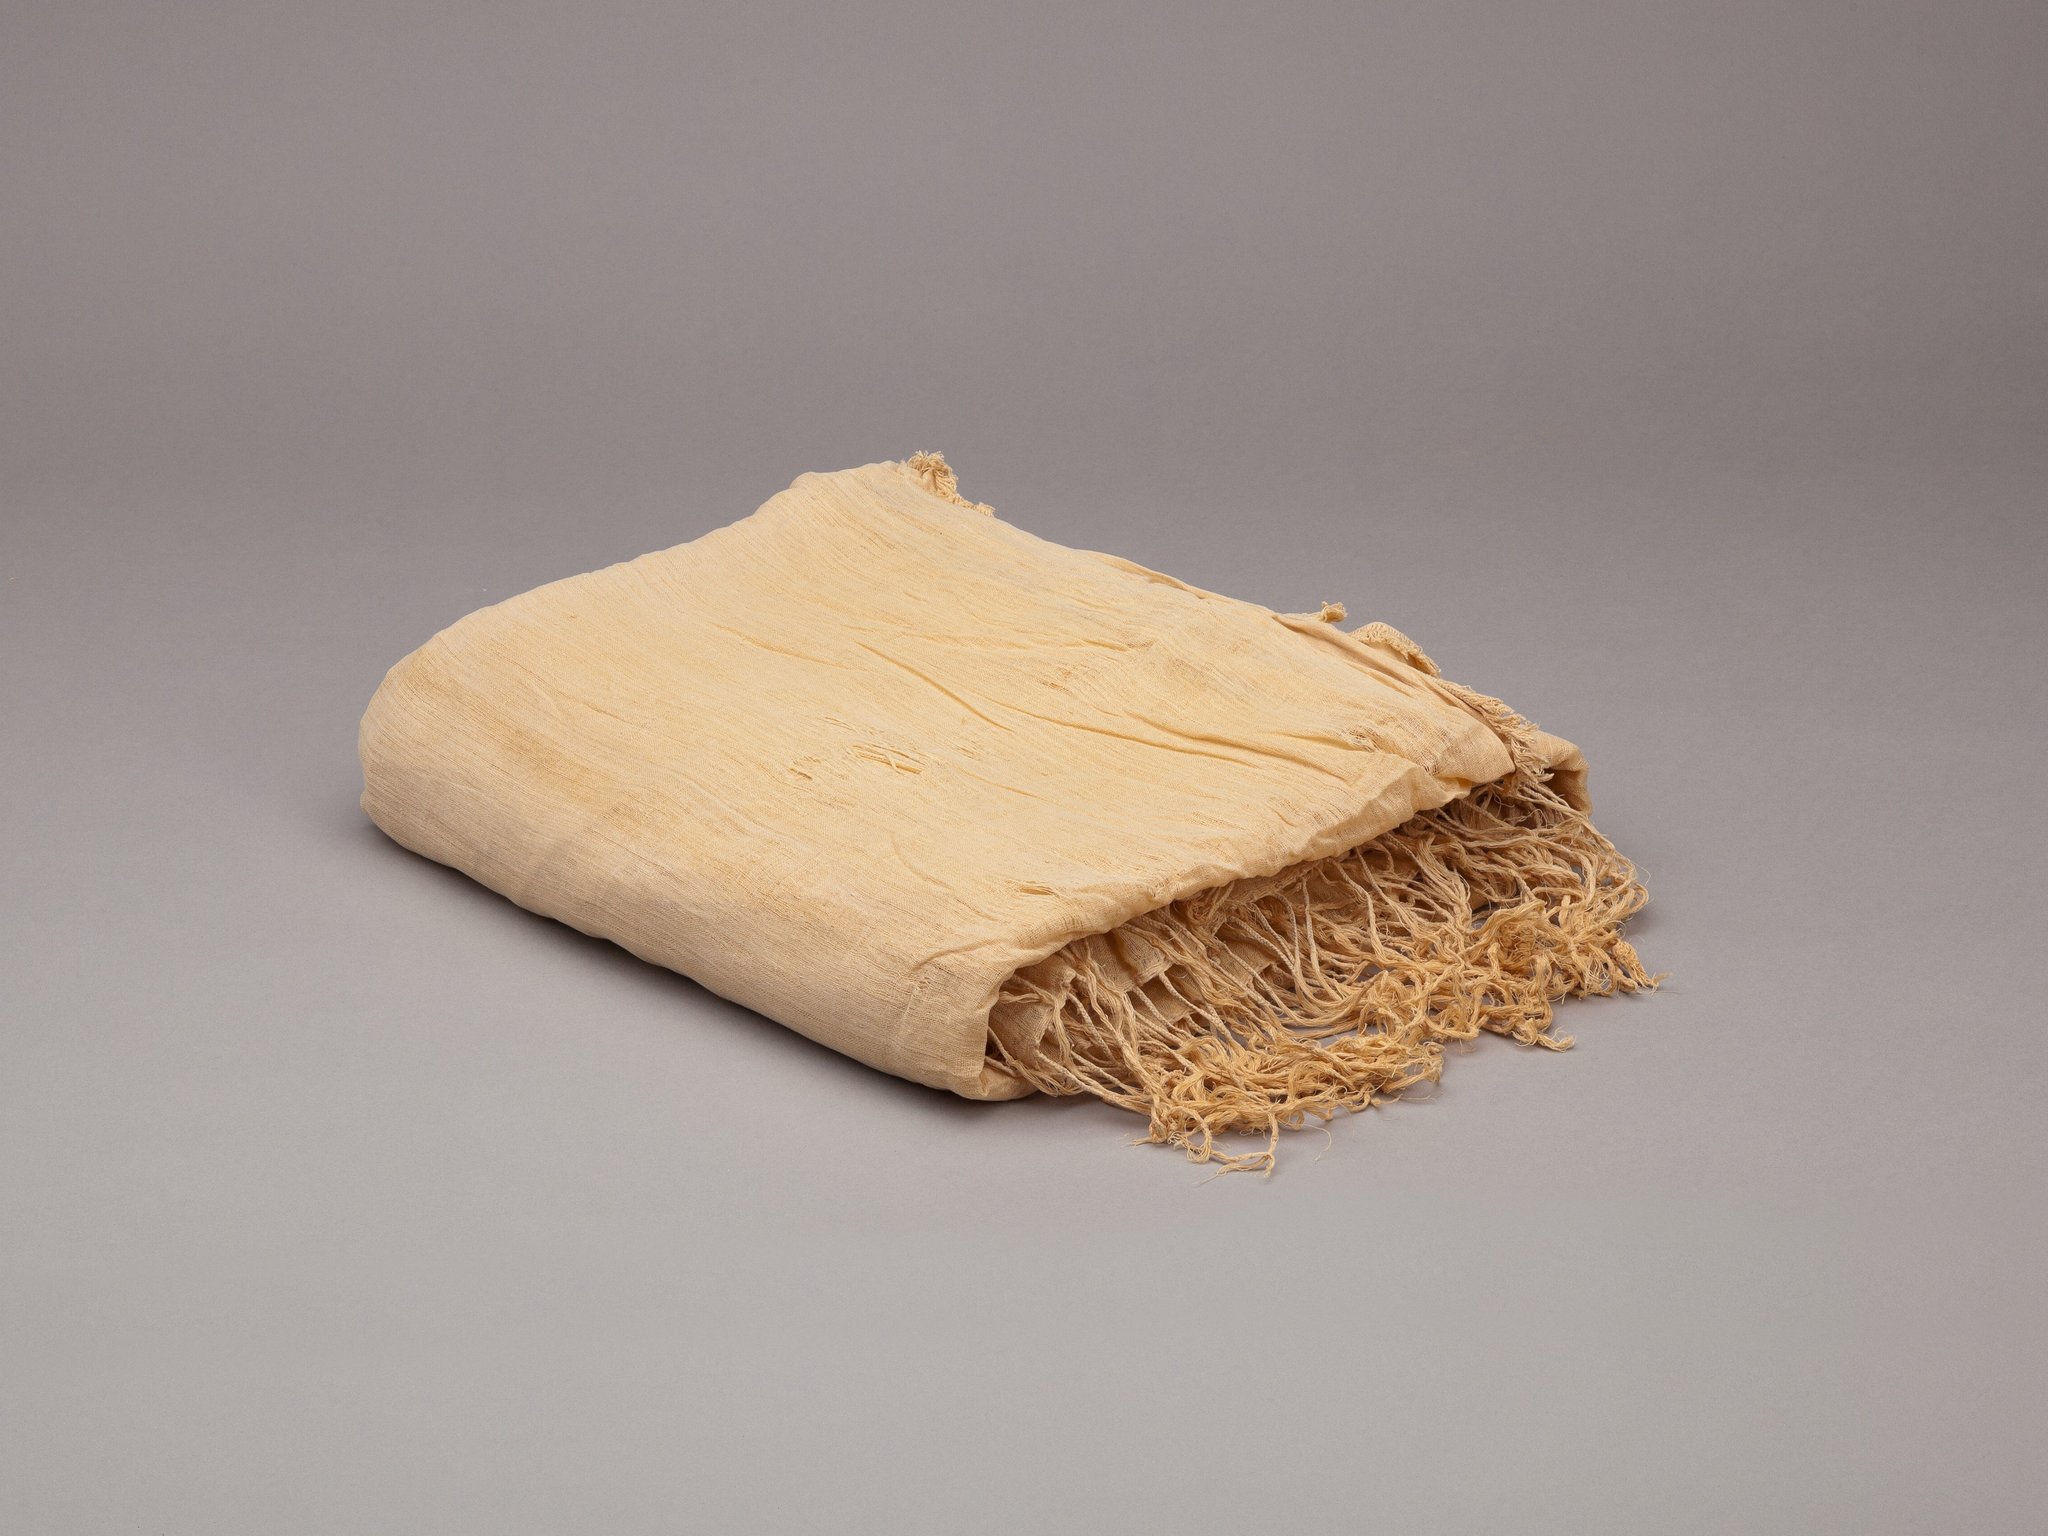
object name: sheet, inscribed, linen mark, medium spin, irregular weave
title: Sheet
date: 1492-1473 BCE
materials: ink, linen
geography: egypt